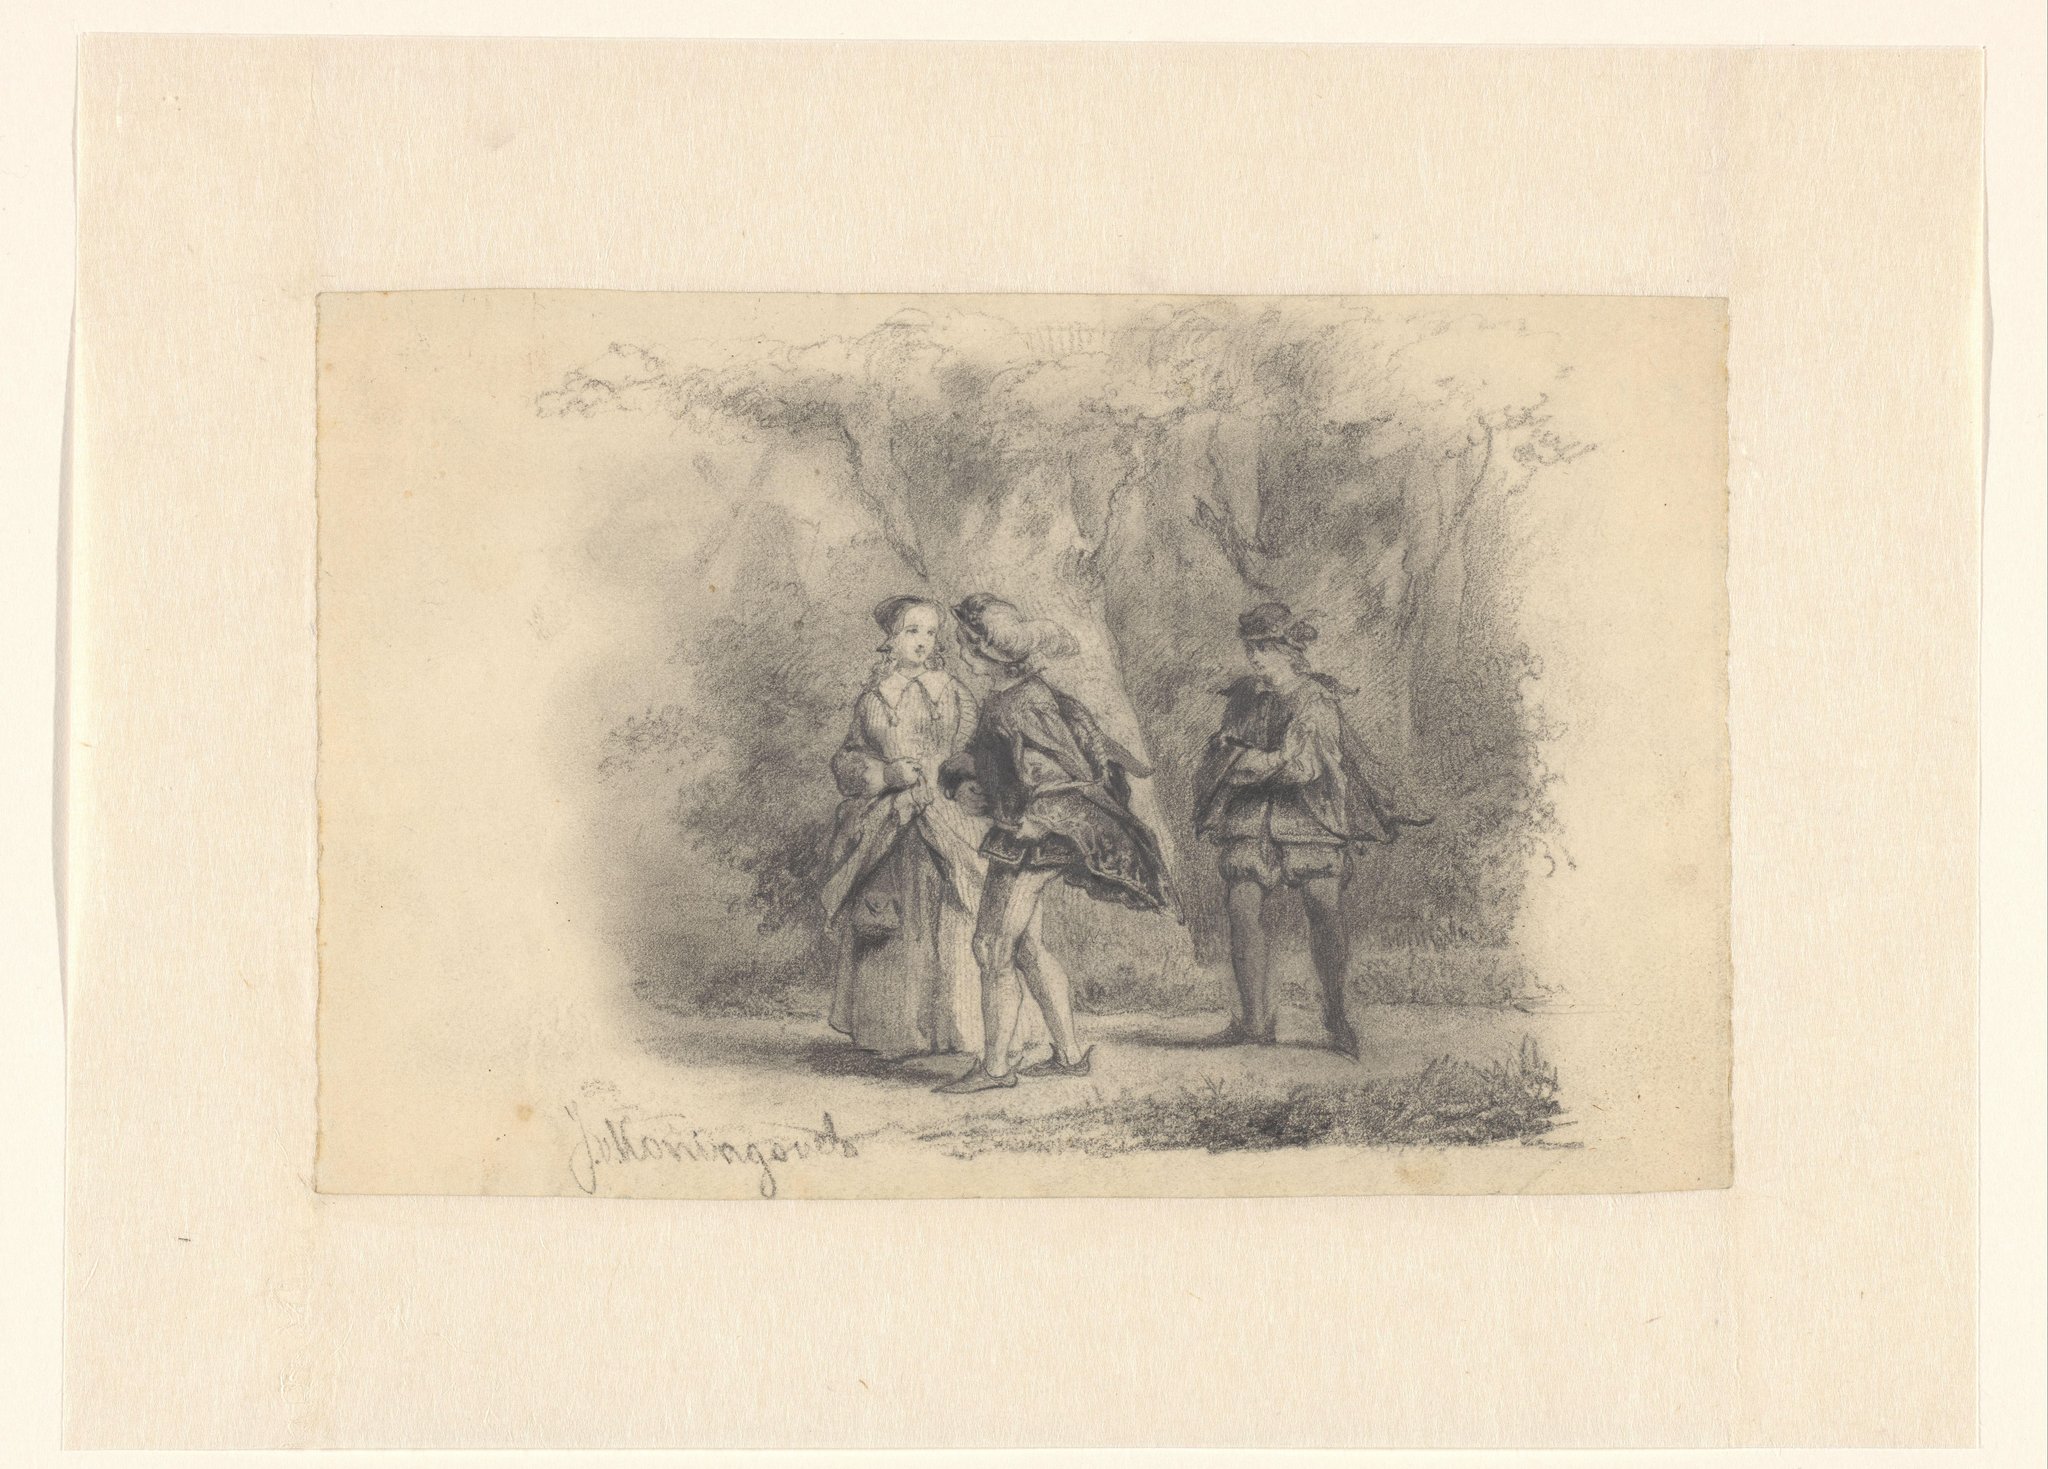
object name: drawing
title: Jong paar in een bos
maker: jacobus van koningsveld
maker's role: draughtsman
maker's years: 1824-1866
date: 1834-1866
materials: paper, pencil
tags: lovers' meeting, forest, wood (+ landscape with figures, staffage)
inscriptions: collector's mark: Lugt 2228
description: Het paar wordt op het bospad gevolgd door een jongeman die met de armen over elkaar loopt.